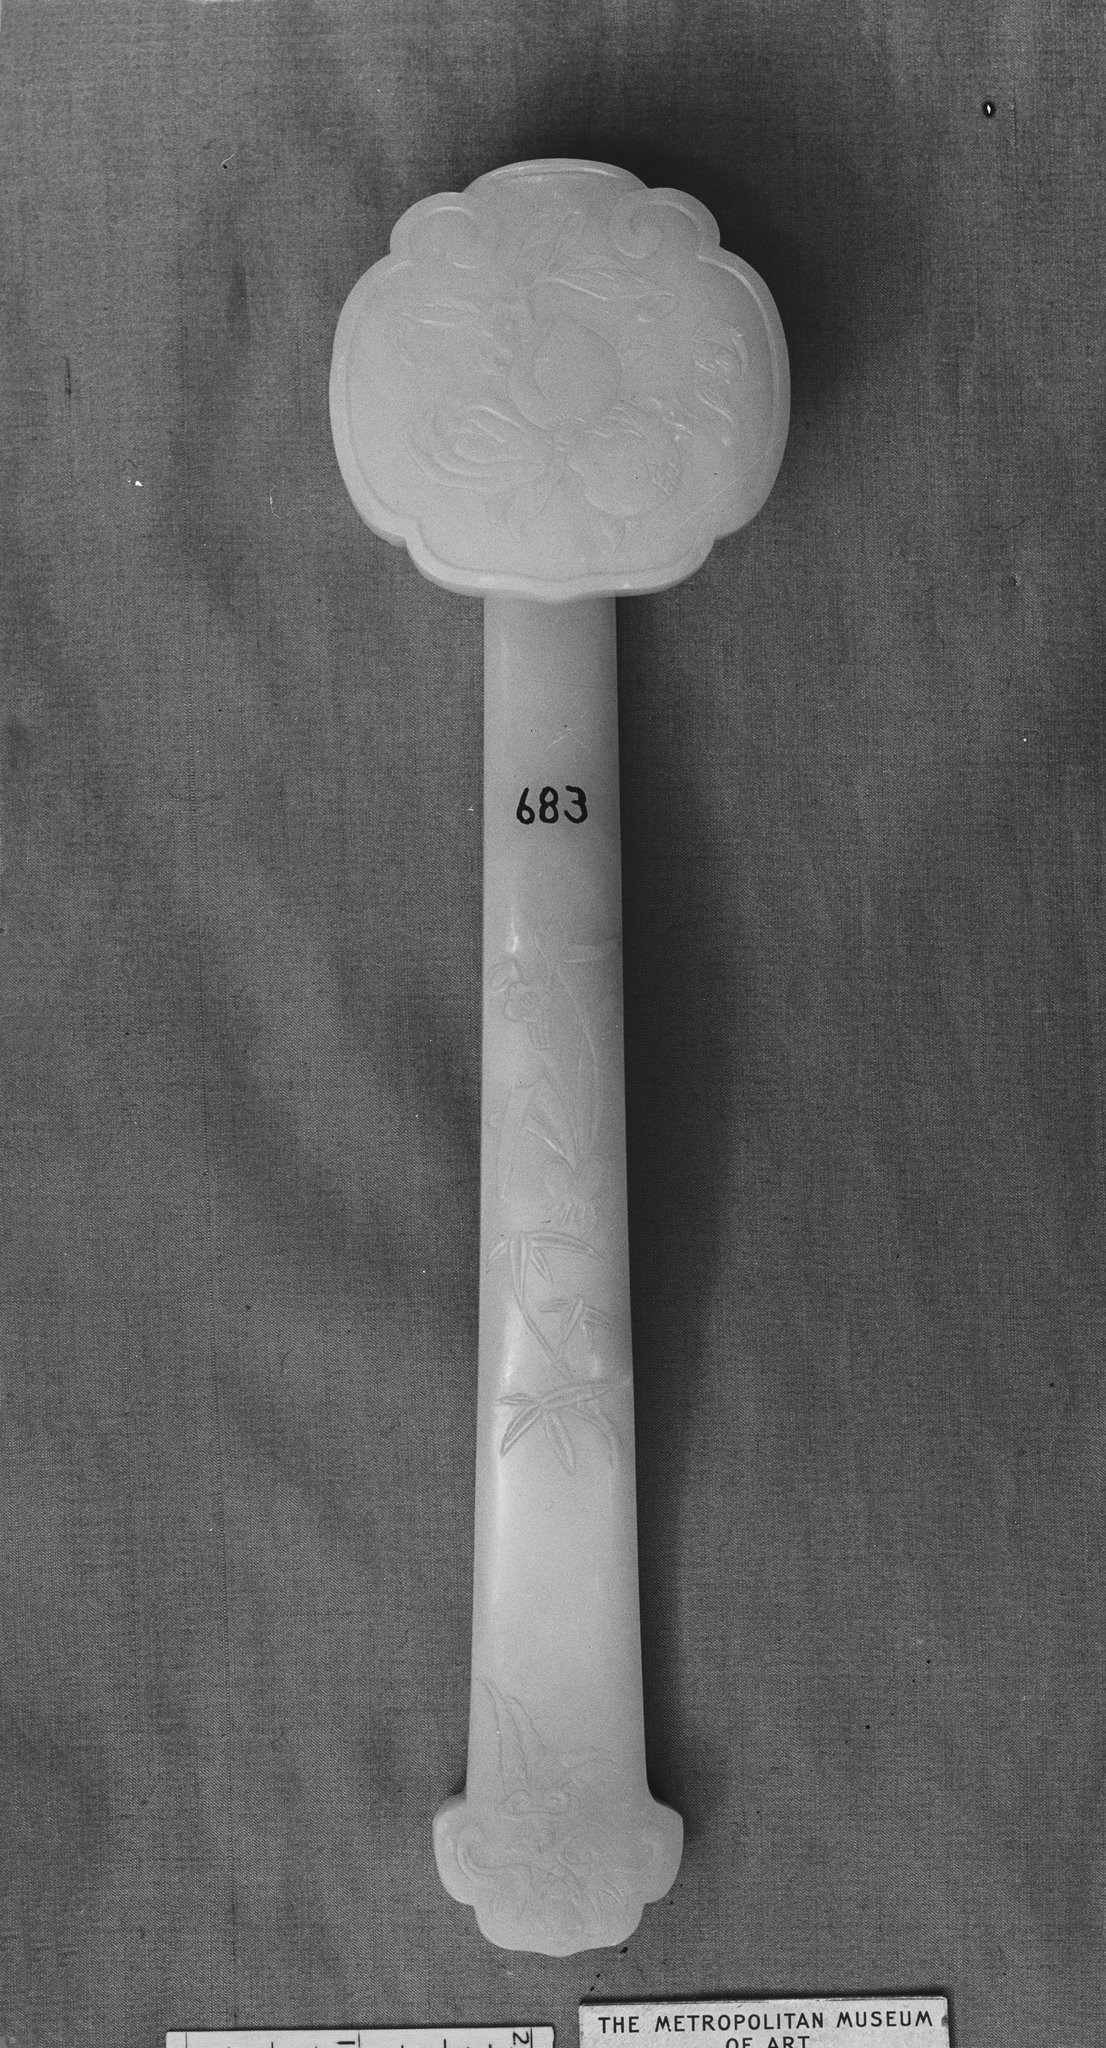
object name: ornament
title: Ornament (ruyi)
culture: chinese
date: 1701-1800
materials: jade